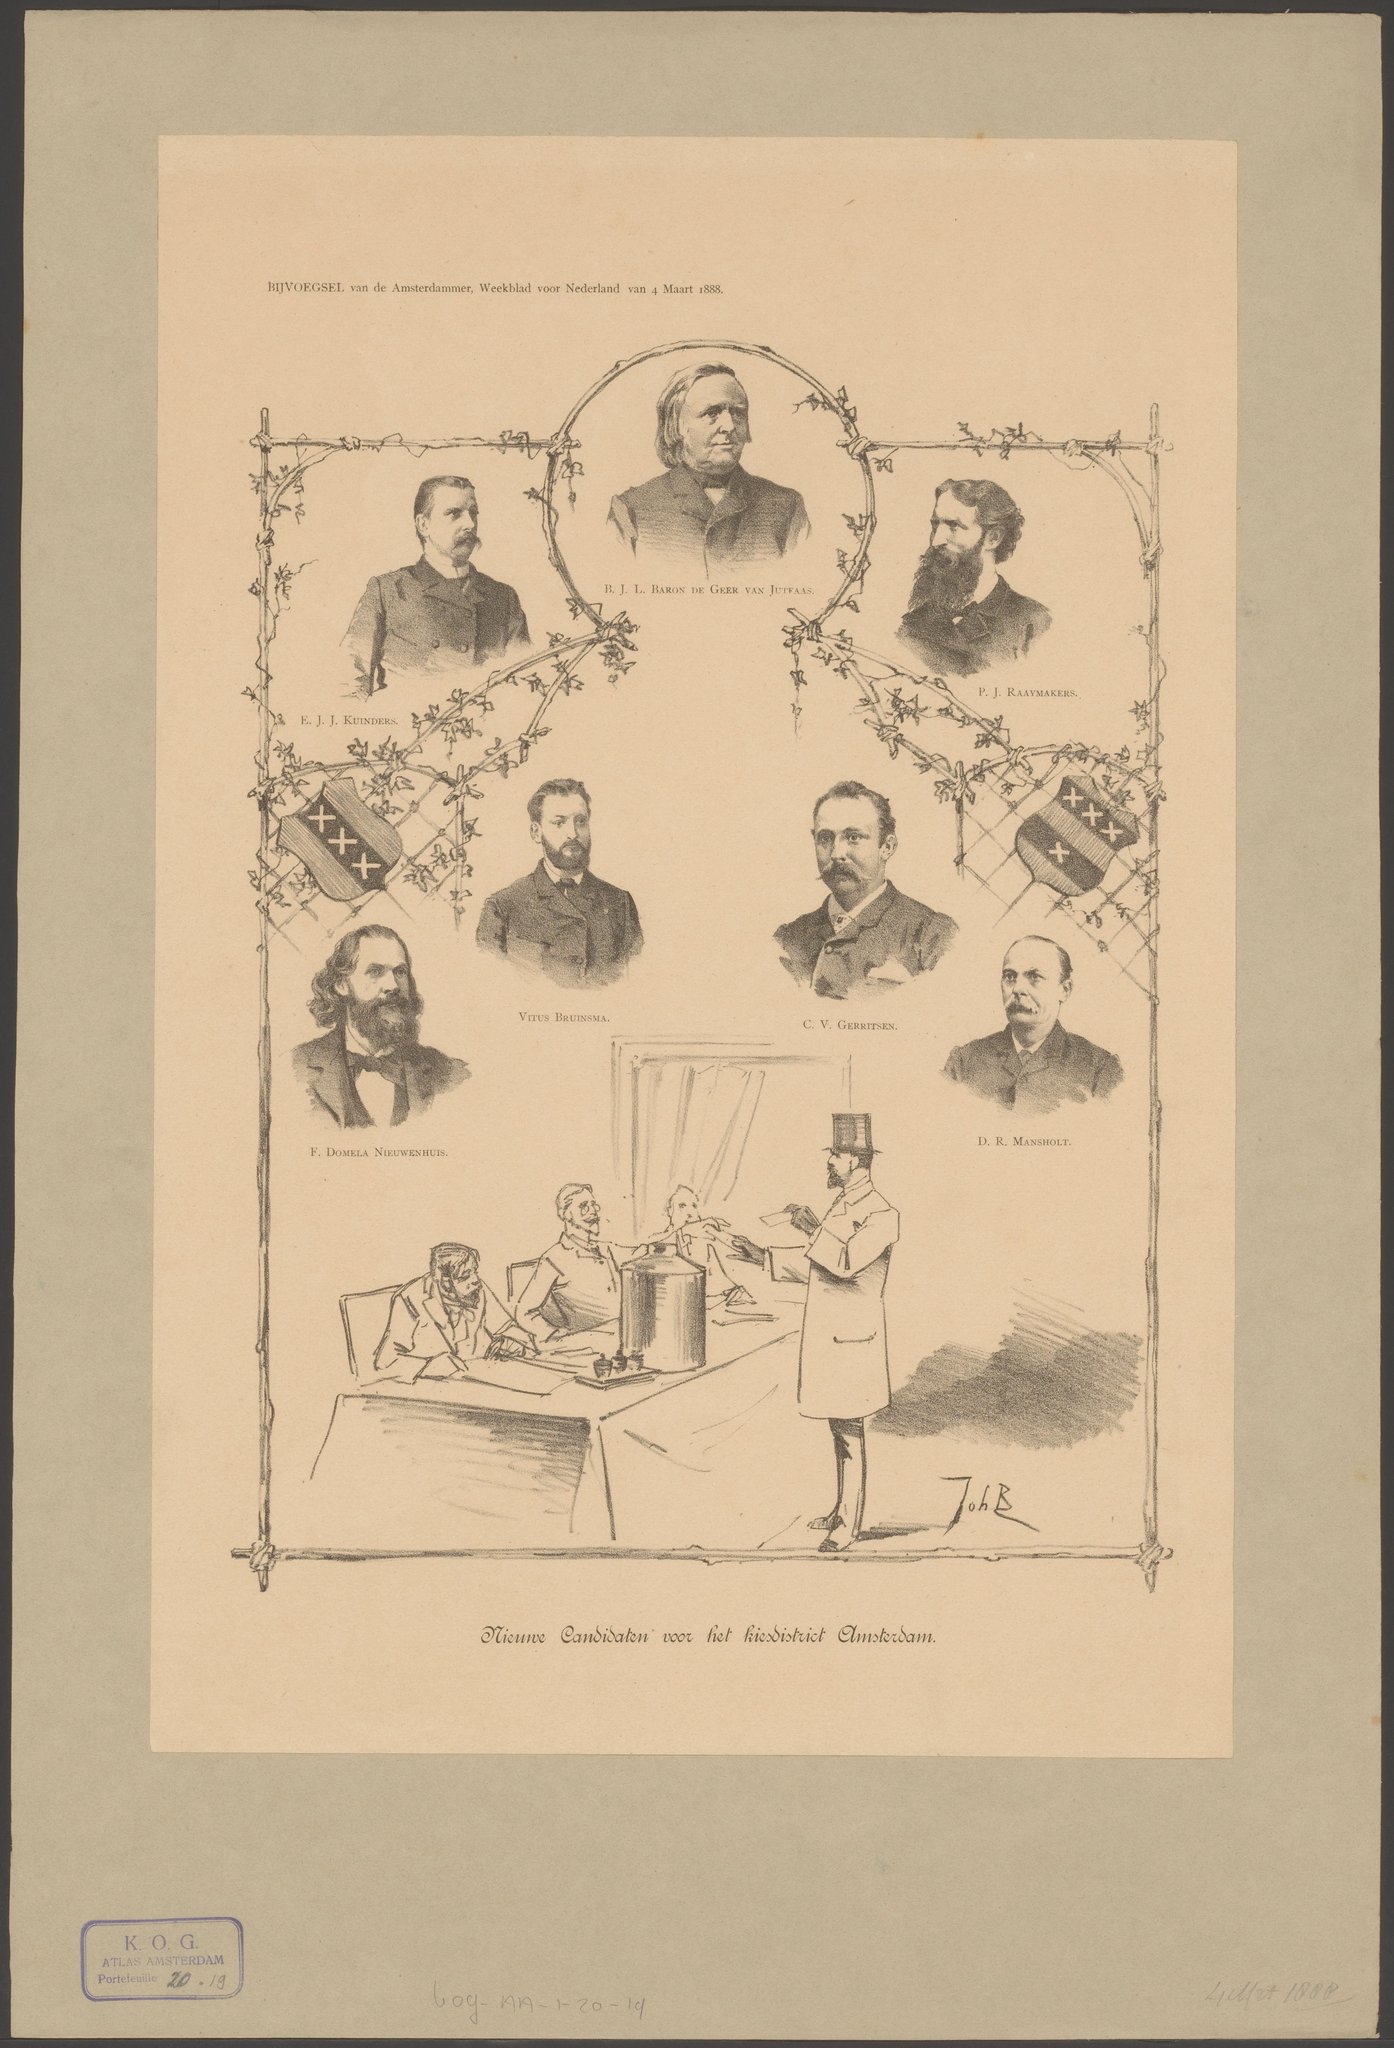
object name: print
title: Nieuwe Candidaten voor het kiesdistrict Amsterdam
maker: johan braakensiek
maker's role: draughtsman, print maker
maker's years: 1858-1940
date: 1888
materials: paper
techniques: letterpress printing, lithograph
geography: netherlands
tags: utrecht, barthold jacob lintelo de geer van jutphaas, rotterdam, germany, groningen (province), politician, ferdinand domela nieuwenhuis, voting, election, voting place, polling station, historical persons, politician, e.g. party leader, amsterdam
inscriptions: collector's mark: Lugt 1641b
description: Portretten van zeven nieuwe kandidaten voor het kiesdistrict Amsterdam bij de komende Tweede Kamerverkiezingen. Onder de portretten een voorstelling van stemmen op het stembureau. Onderwerpsrubriek binnen de Atlas Amsterdam: Verkiezingen Tweede Kamer.